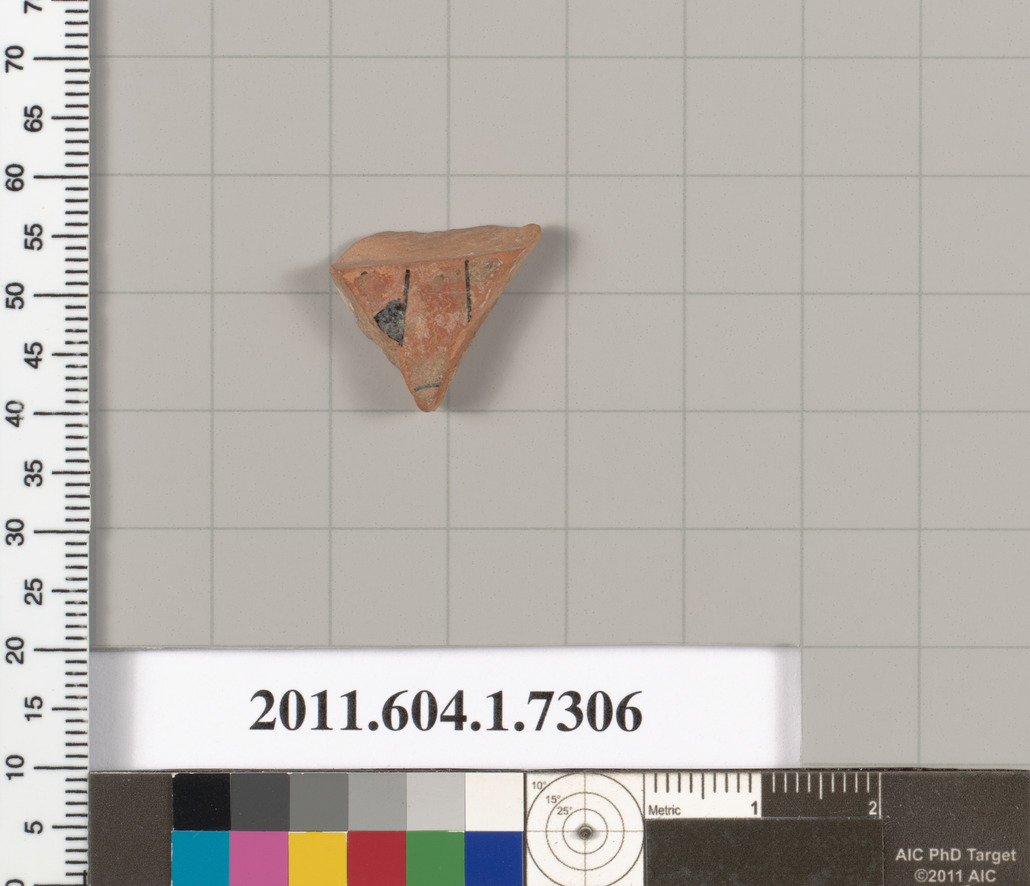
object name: kylix fragment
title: Terracotta fragment of a kylix (drinking cup)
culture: greek, attic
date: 500-480 BCE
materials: terracotta